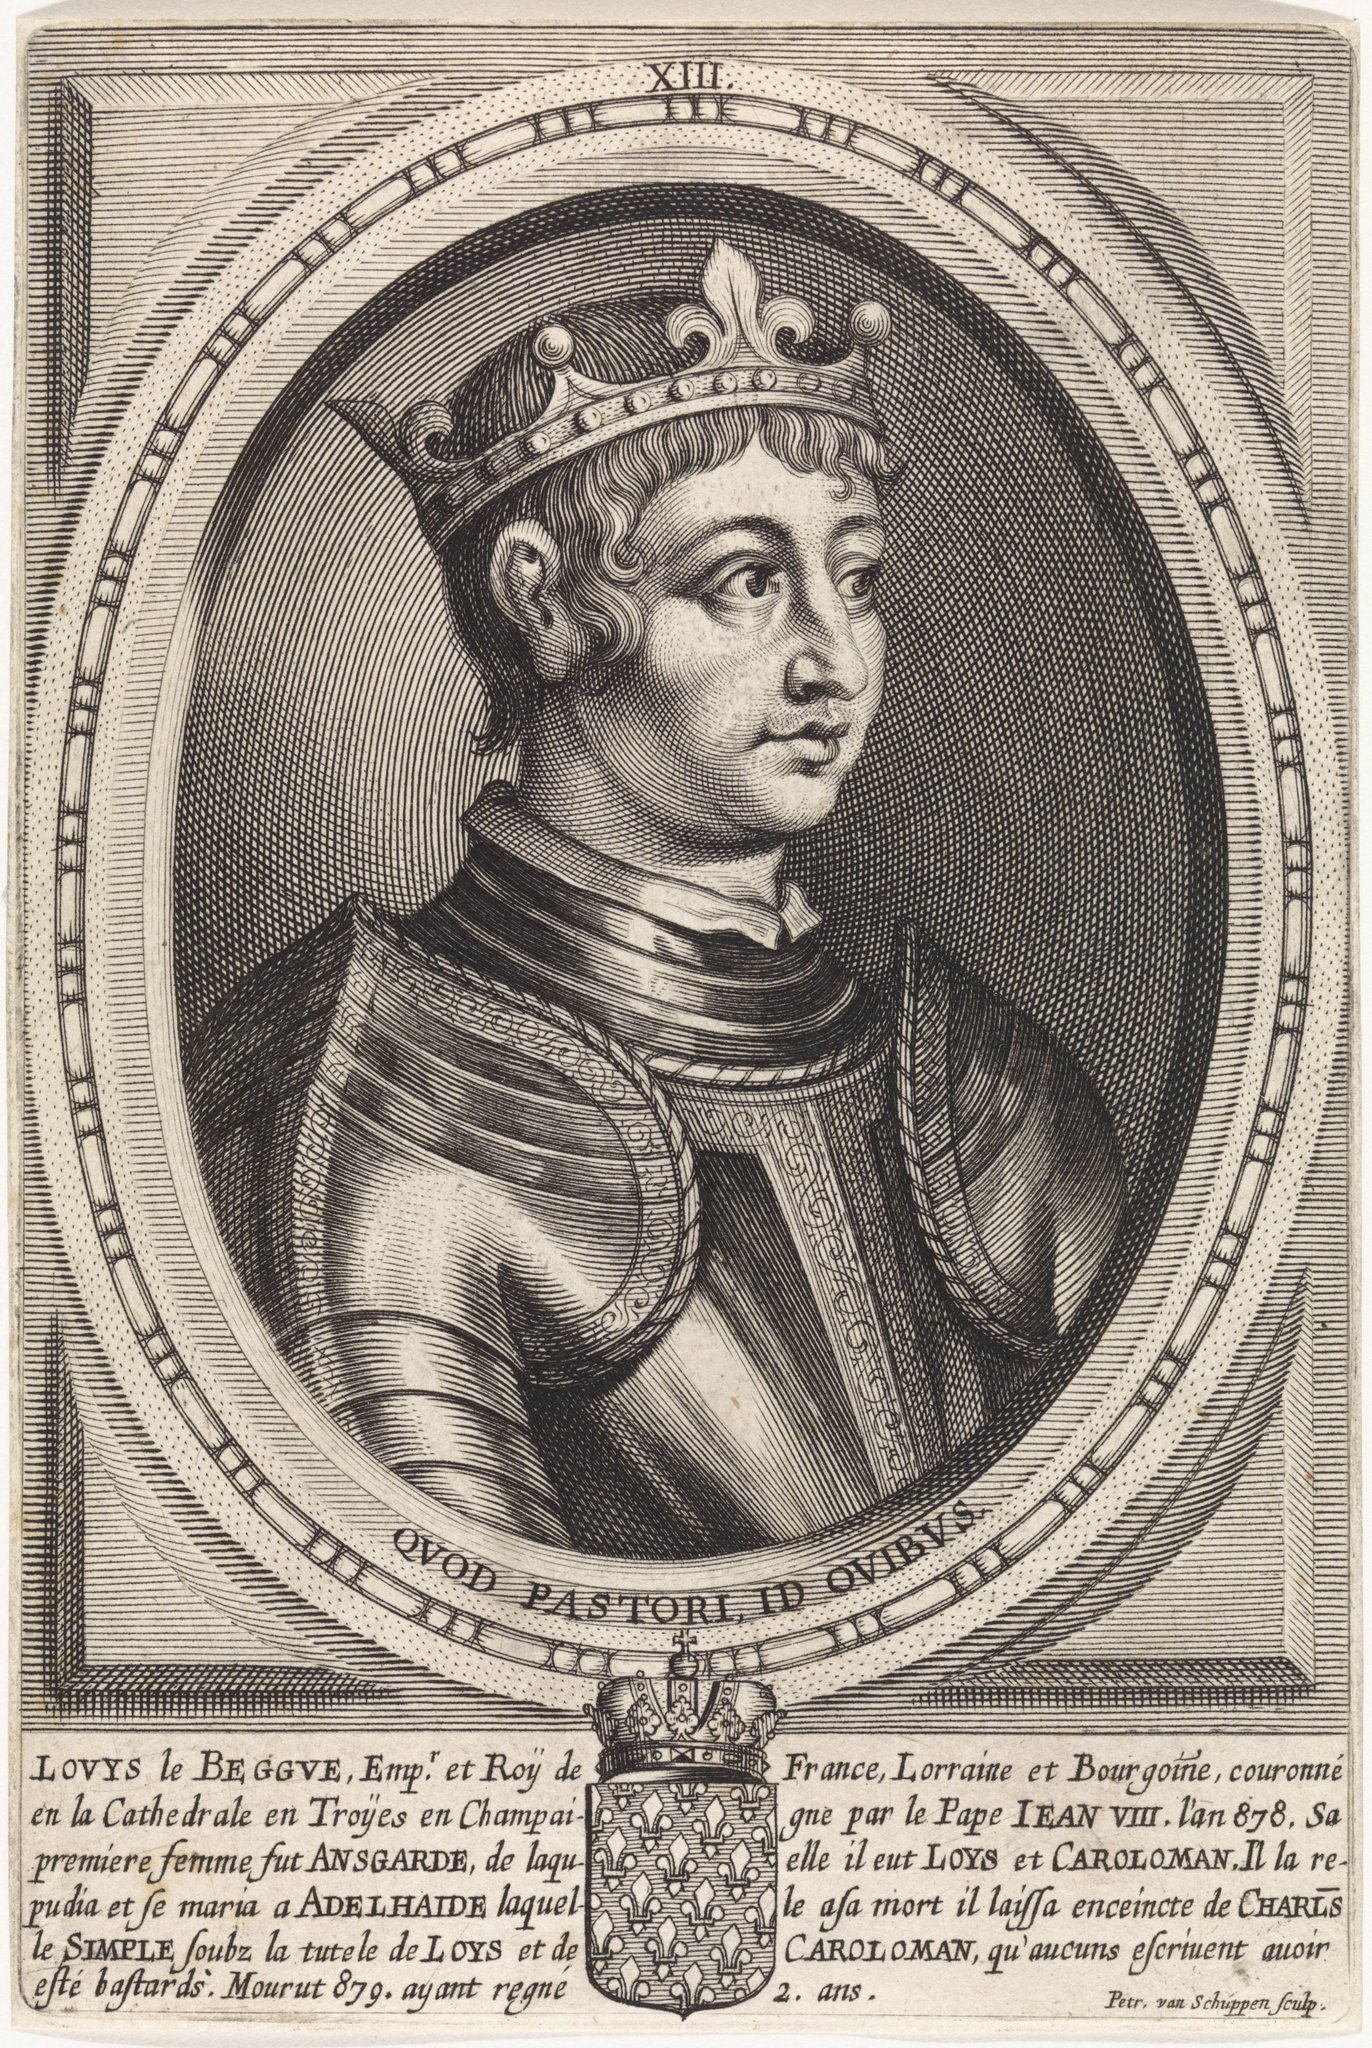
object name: book illustration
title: Portret van Lodewijk de Stamelaar, koning van Frankrijk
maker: pieter van schuppen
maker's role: print maker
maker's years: 1627-1702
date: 1660-1669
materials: paper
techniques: engraving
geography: paris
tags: compiègne, koning, lodewijk ii (de stamelaar)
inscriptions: collector's mark: Lugt 240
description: Portret van Lodewijk de Stamelaar met diens spreuk en ingekleurd wapenschild. Onder het portret een korte levensbeschrijving. Bovenaan genummerd 'XIII.'.